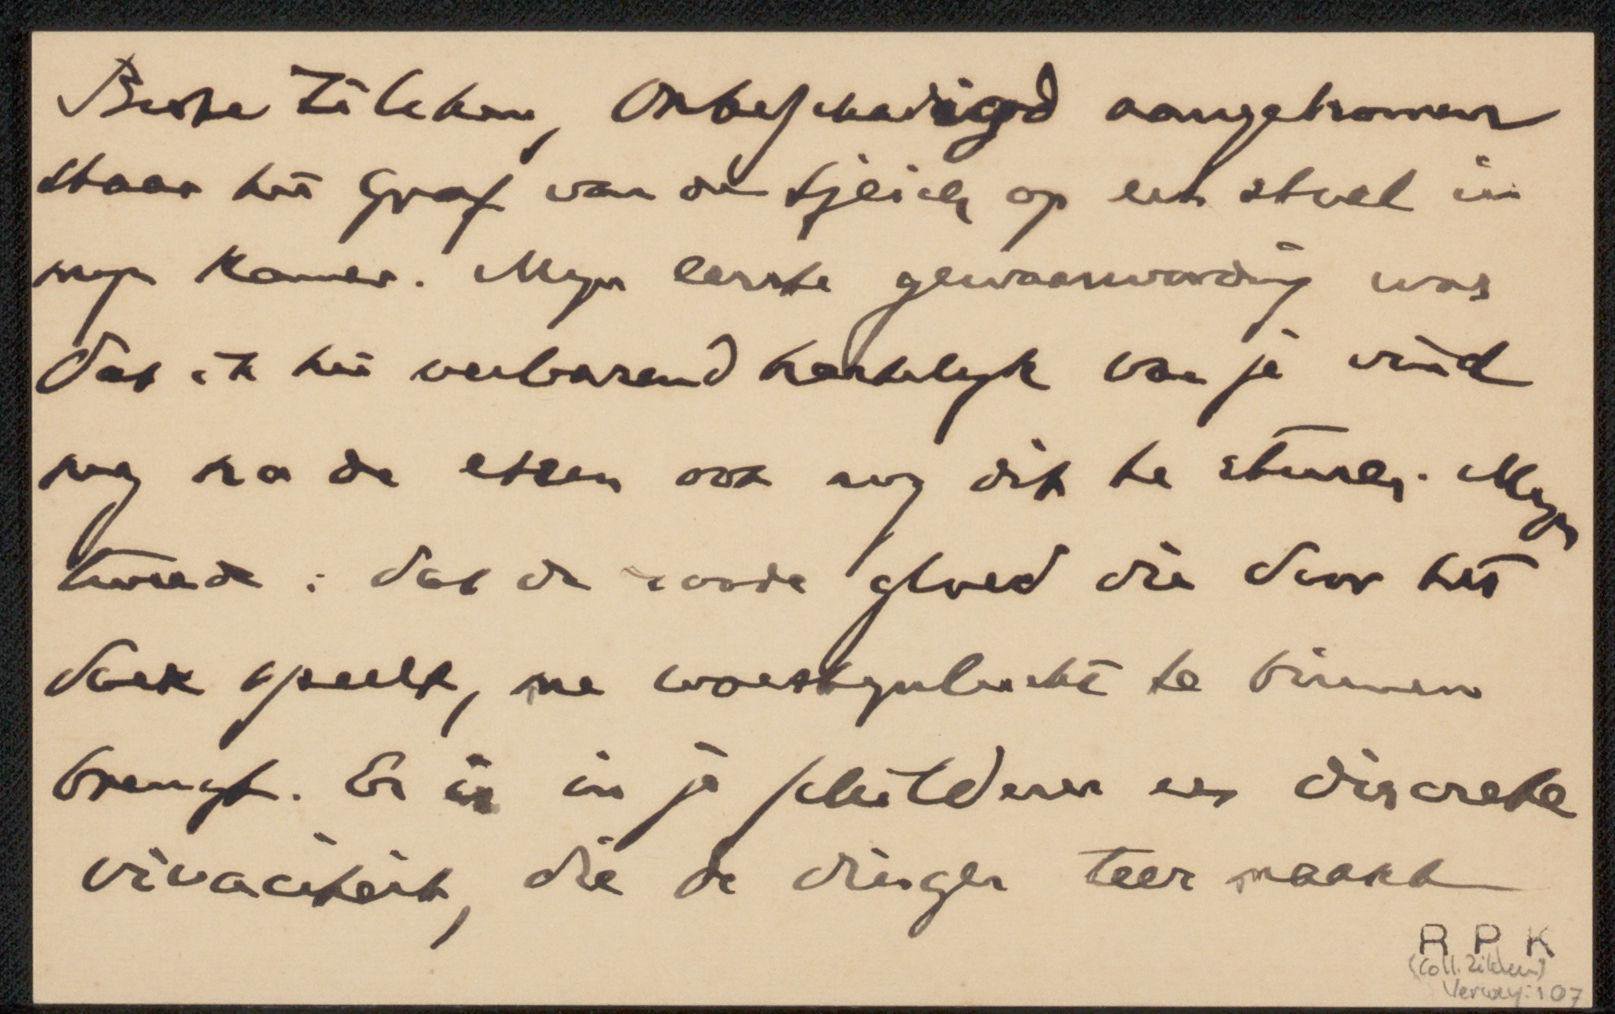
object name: letter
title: Brief aan Philip Zilcken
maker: albert verwey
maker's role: criticus, dichter, essayist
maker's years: 1865-1937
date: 1916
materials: cardboard, ink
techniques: pen, writing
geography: noordwijk aan zee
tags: the hague, painter, philip zilcken, the graphic arts, diseases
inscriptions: collector's mark: ‘RPK’